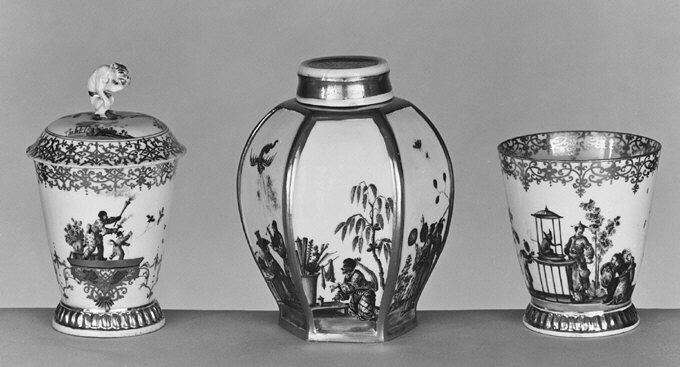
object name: beaker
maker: meissen manufactory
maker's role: manufactory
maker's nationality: german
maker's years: 1710-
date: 1725-1730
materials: hard paste porcelain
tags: chinoiserie,men